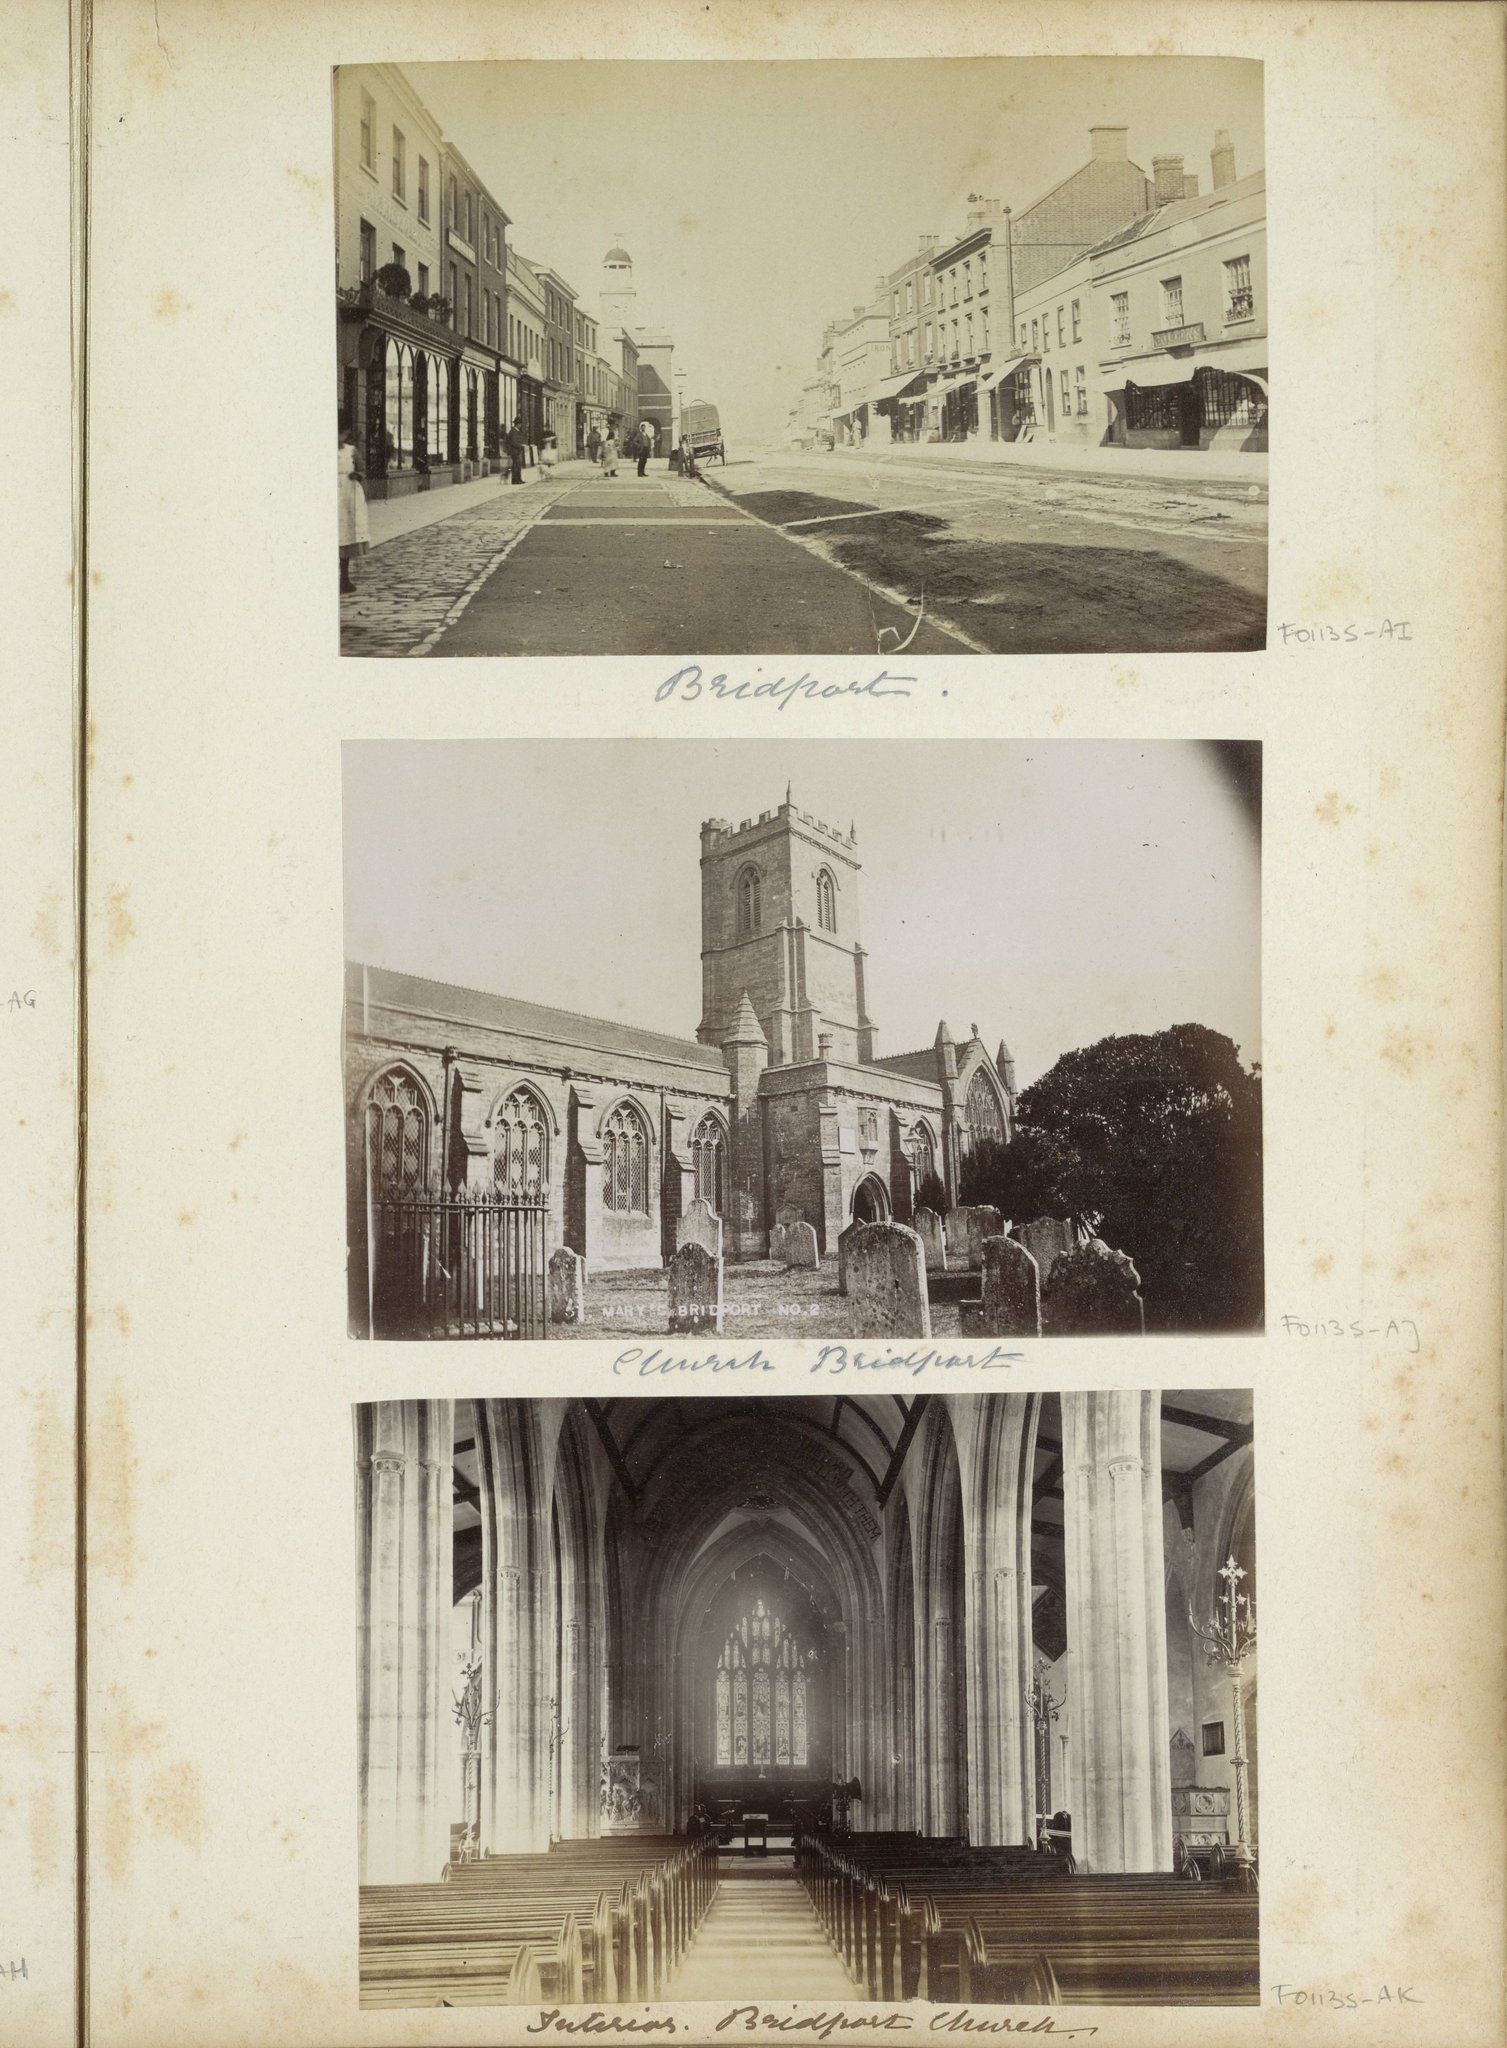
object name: album leaf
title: [(...)] Mary's Bridport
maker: Anonymous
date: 1898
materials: paper, photographic support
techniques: albumen print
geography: bridport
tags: church (exterior), churchyard, cemetery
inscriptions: number: ‘2’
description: Onderdeel van Reisalbum met foto's van bezienswaardigheden in Engeland en Frankrijk.